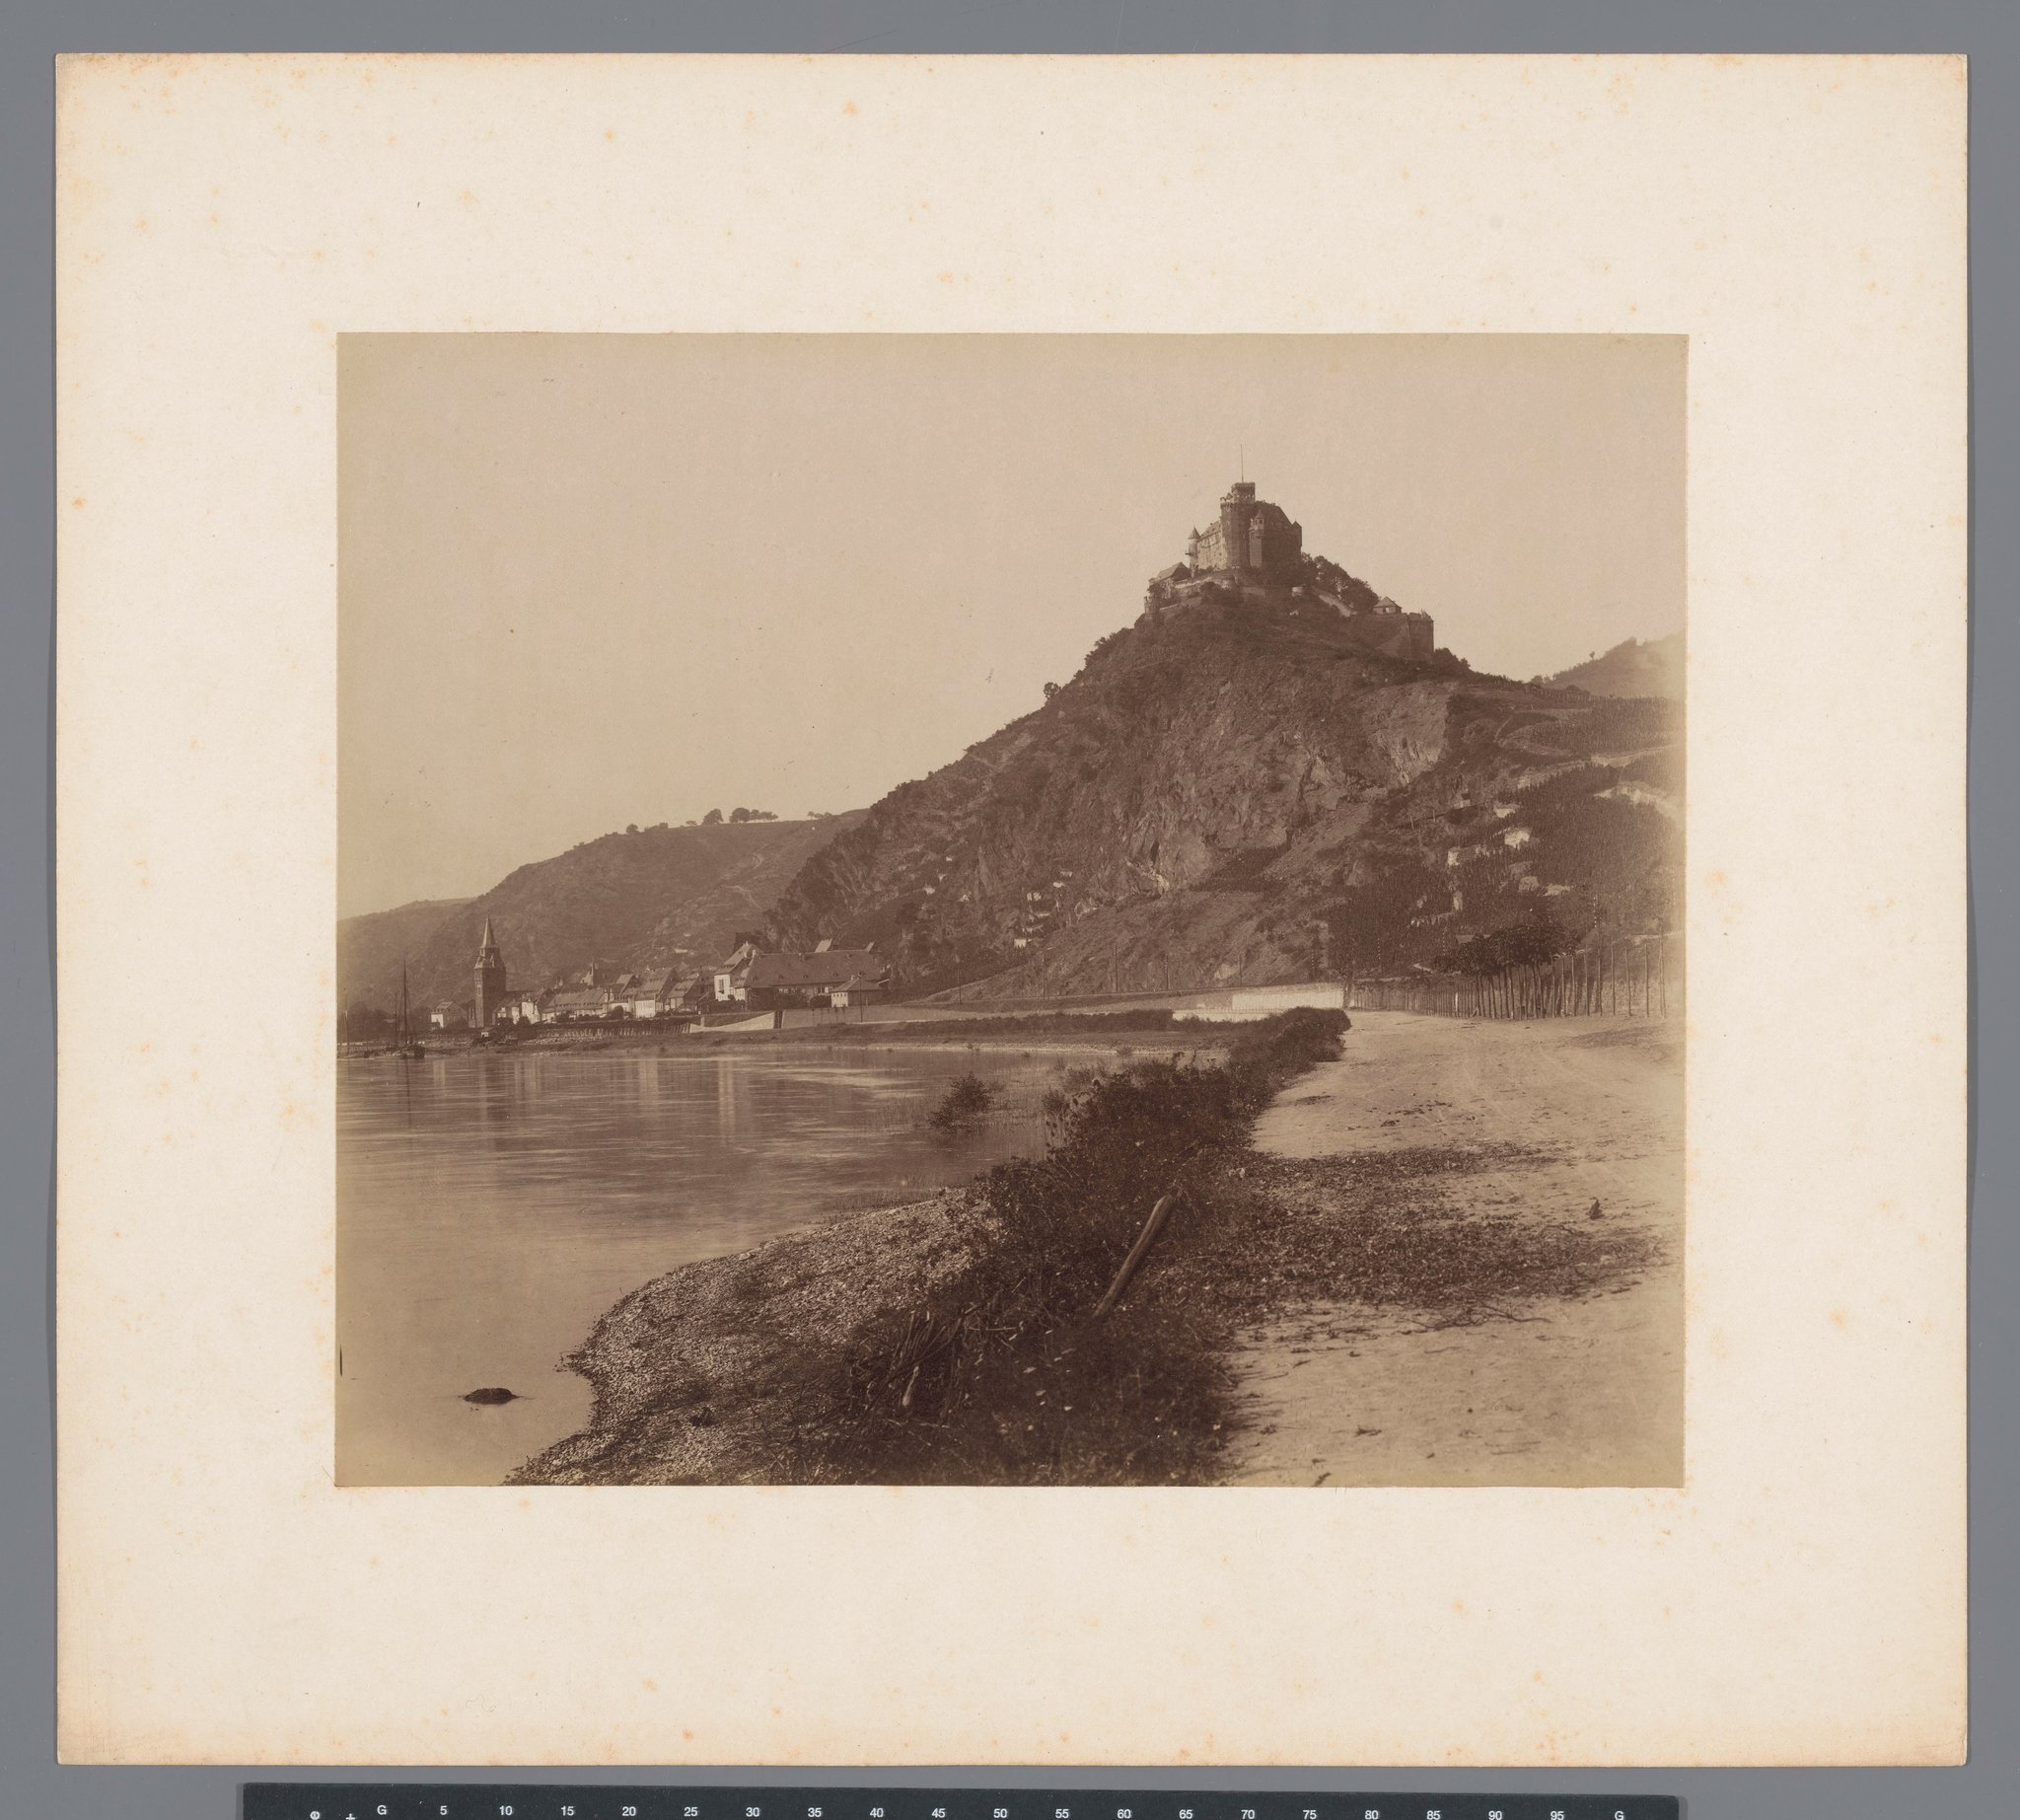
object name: photograph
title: Gezicht op Braubach aan de Rijn en de Marksburg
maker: Anonymous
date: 1883-1900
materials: cardboard, paper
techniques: albumen print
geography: braubach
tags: river, landscape with tower or castle, braubach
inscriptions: inscription: ‘4 Dinsdag 18 Juli/ Braubach & die Marksburg/ 4’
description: Deze foto maakt deel uit van een fotoserie, gemaakt of gekocht door een Nederlandse reiziger die onderweg was in Duitsland, Oostenrijk en Italië tussen 27 juni en 29 juli. Het jaartal van de reis is onbekend, maar de foto's zijn waarschijnlijk gemaakt tussen 1883 en 1900.